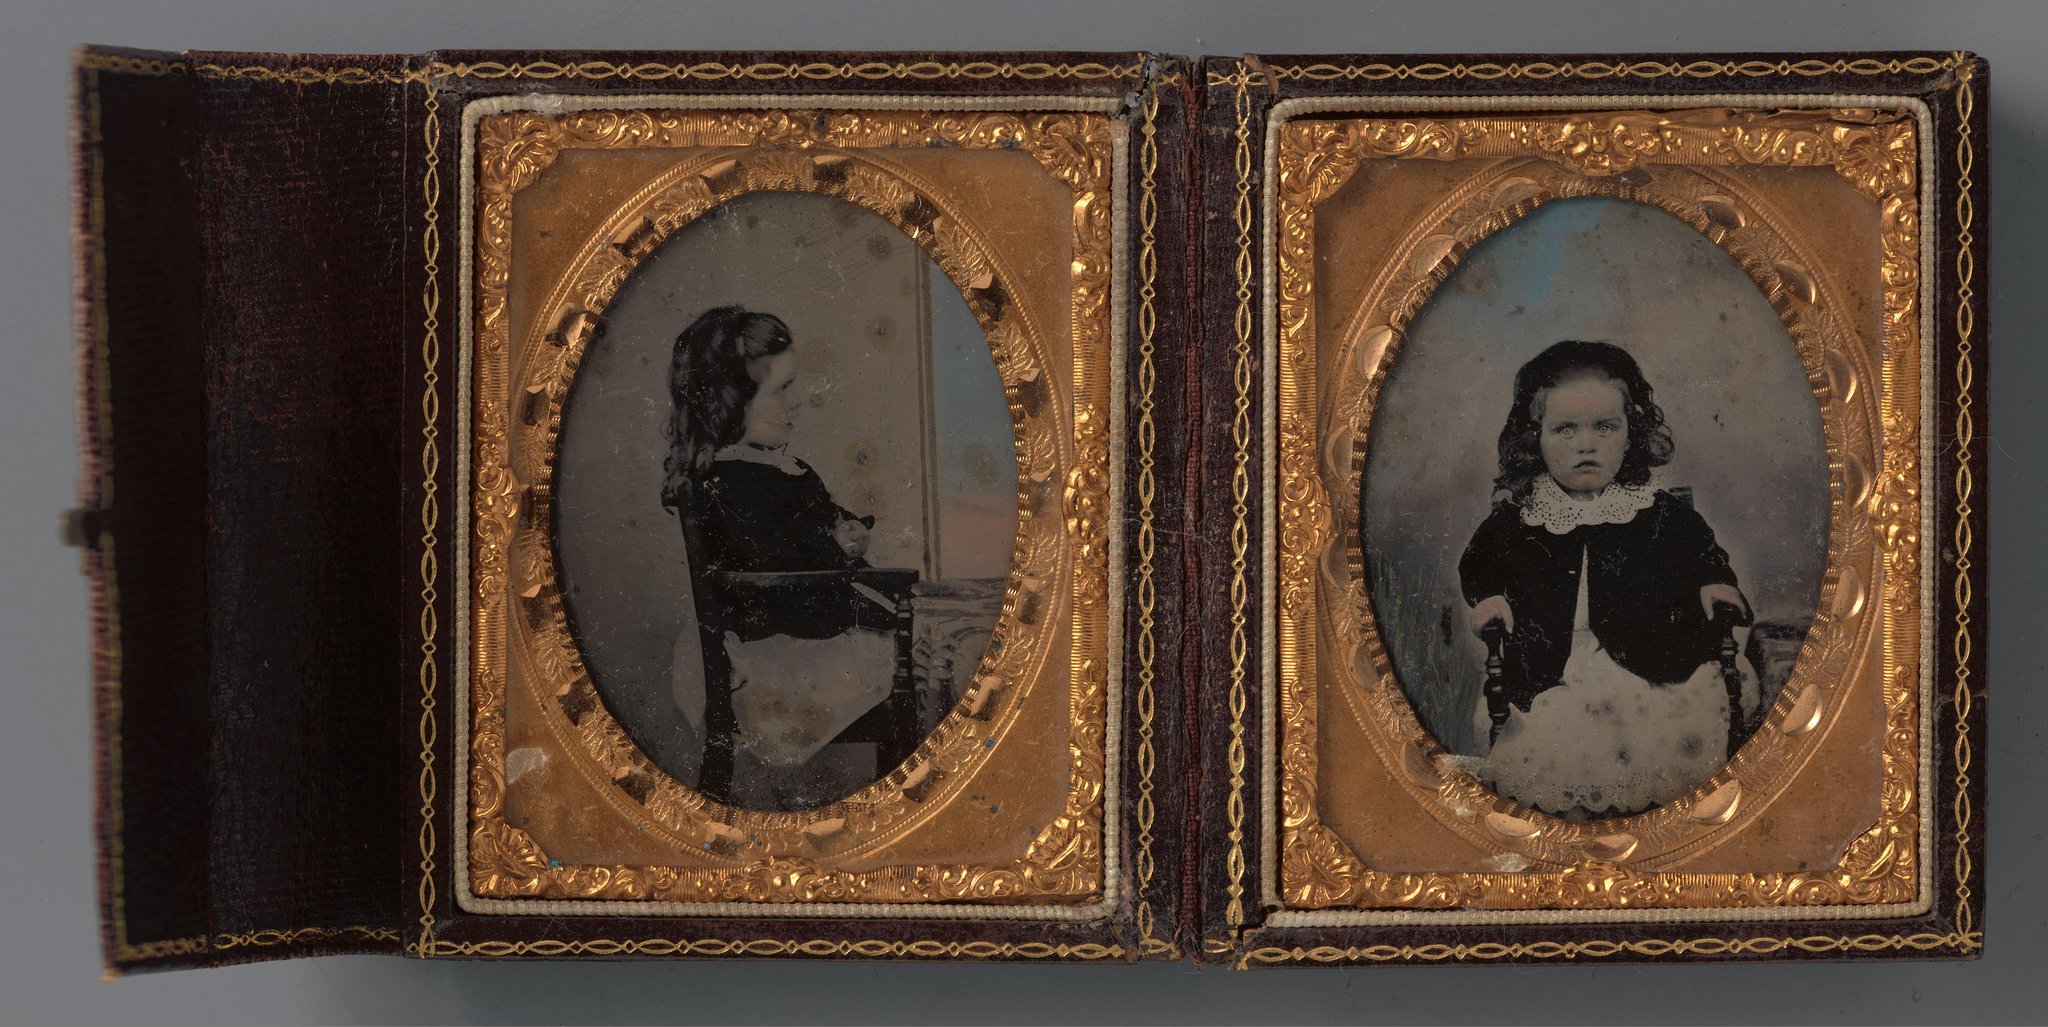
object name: photograph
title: Portret van een onbekend zittend meisje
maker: Anonymous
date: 1860-1870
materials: glass, leather, metal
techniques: ambrotype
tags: sitting figure - aa - female human figure, historical persons - bb - woman, toddler (female)